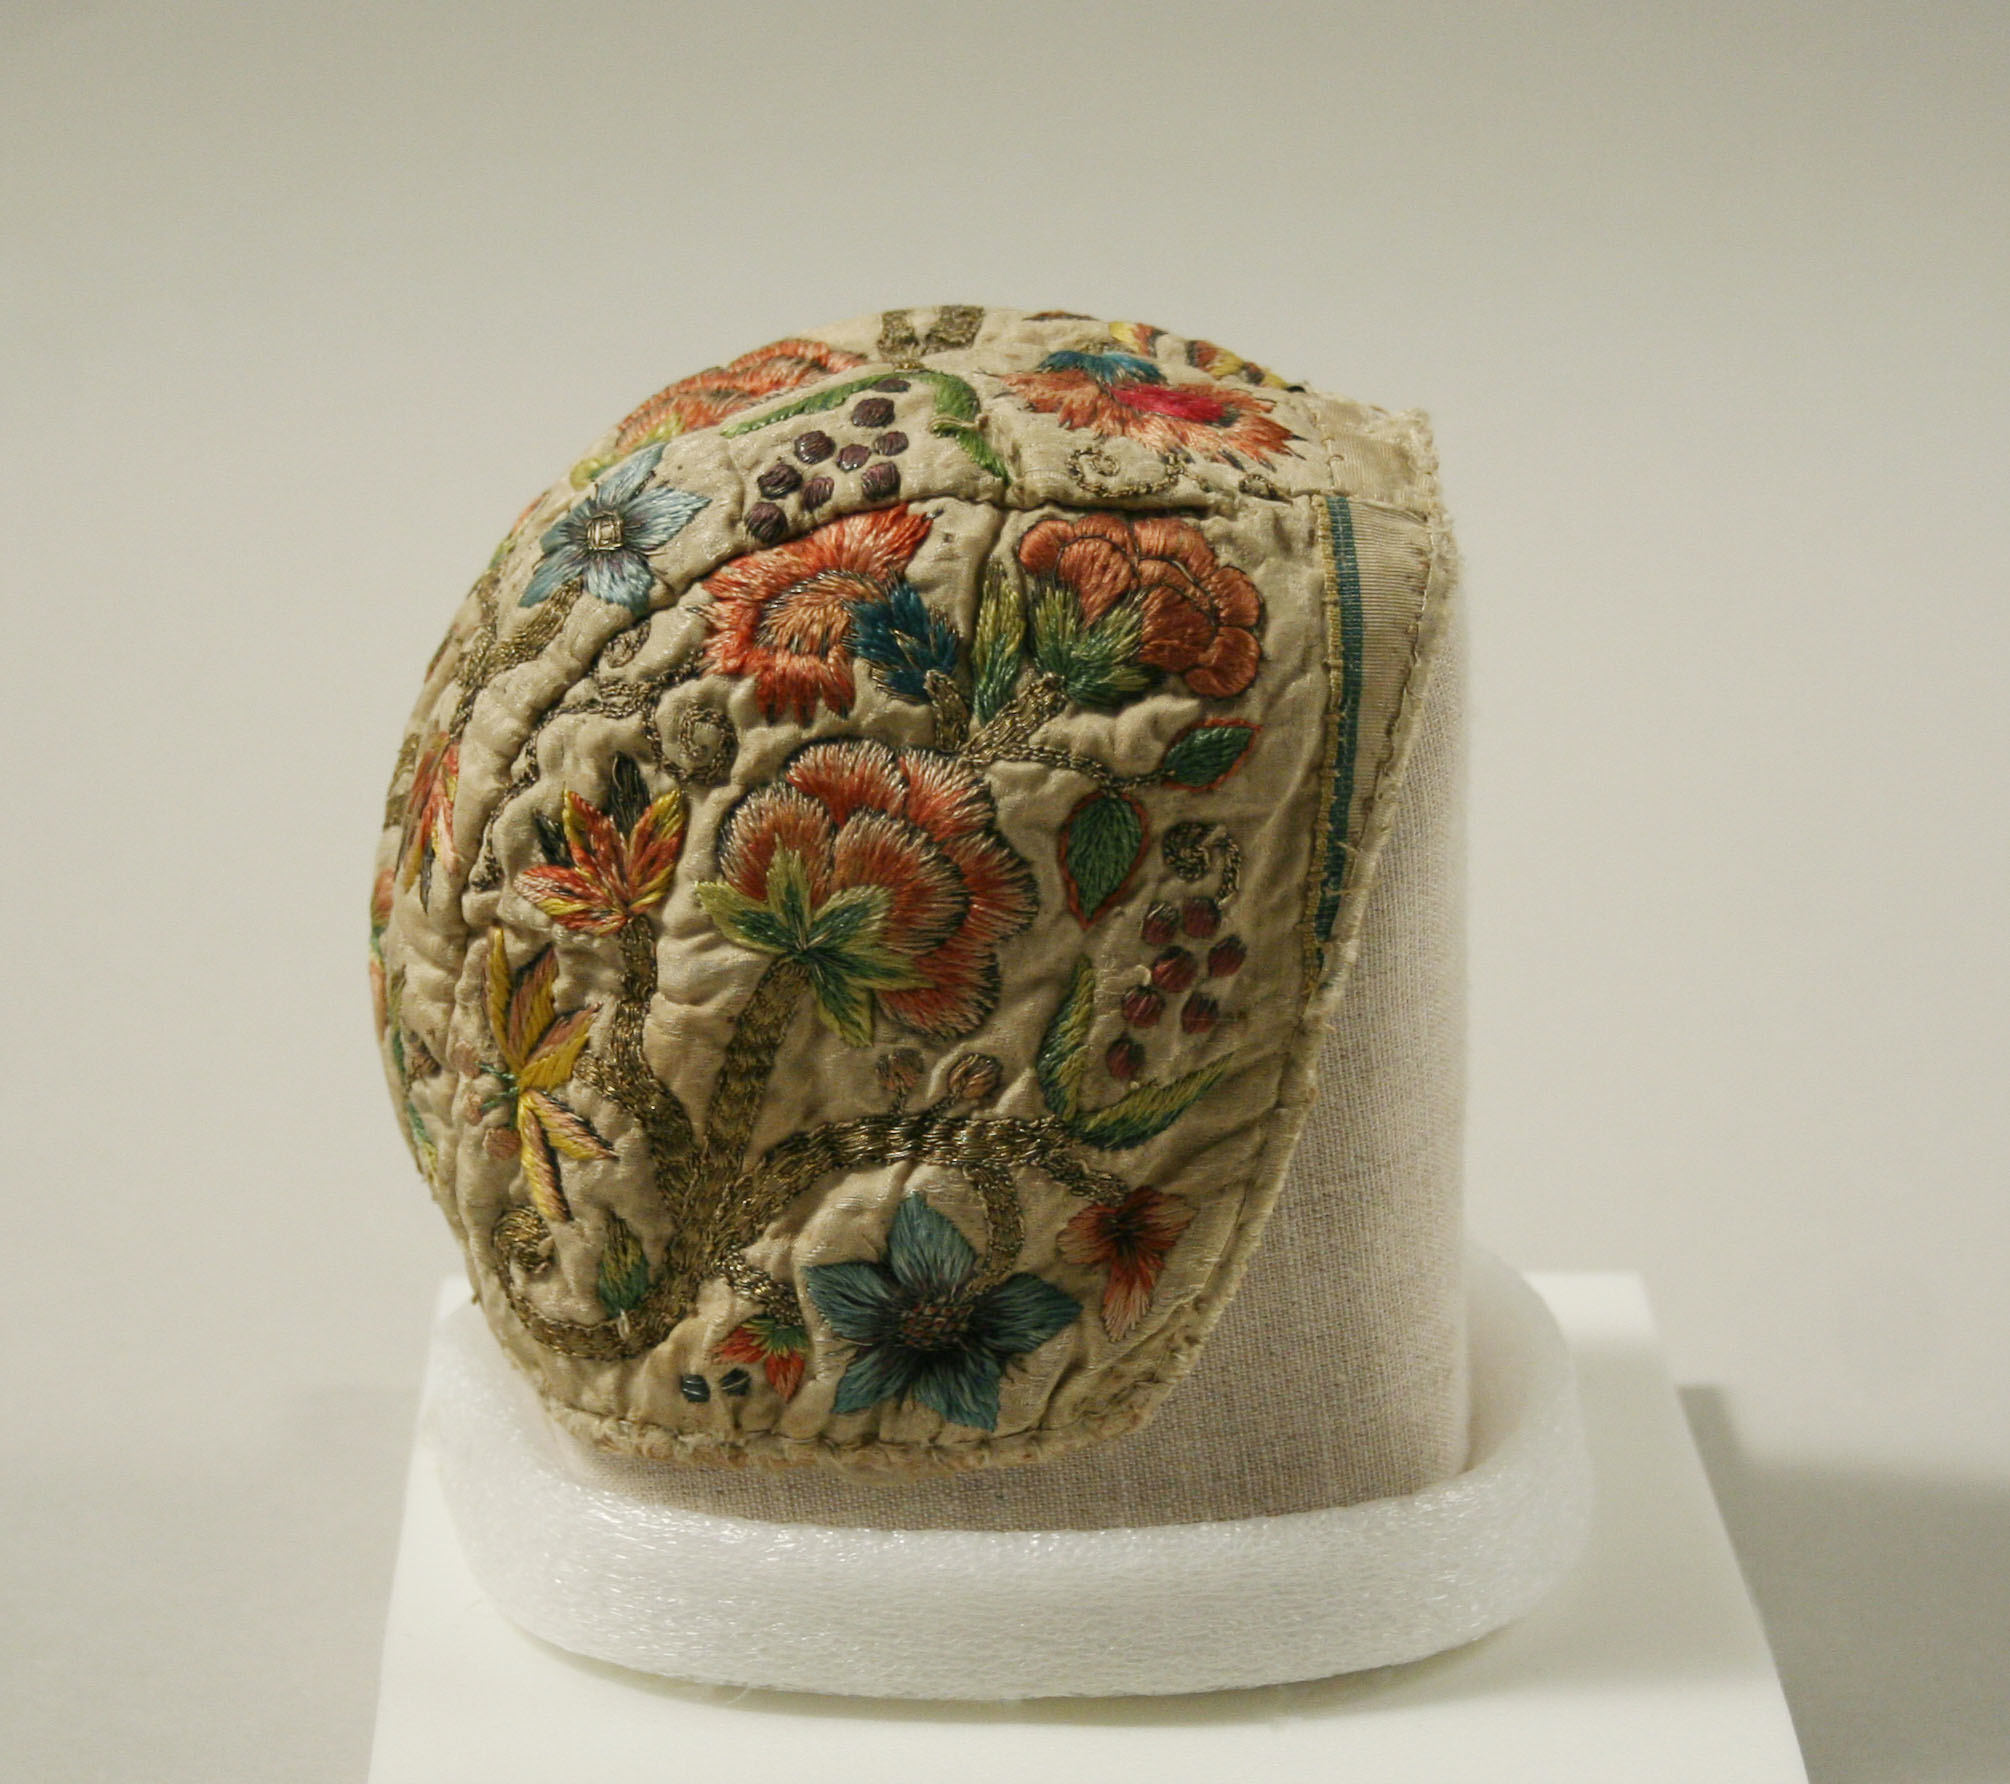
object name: cap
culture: german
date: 1701-1800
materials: silk